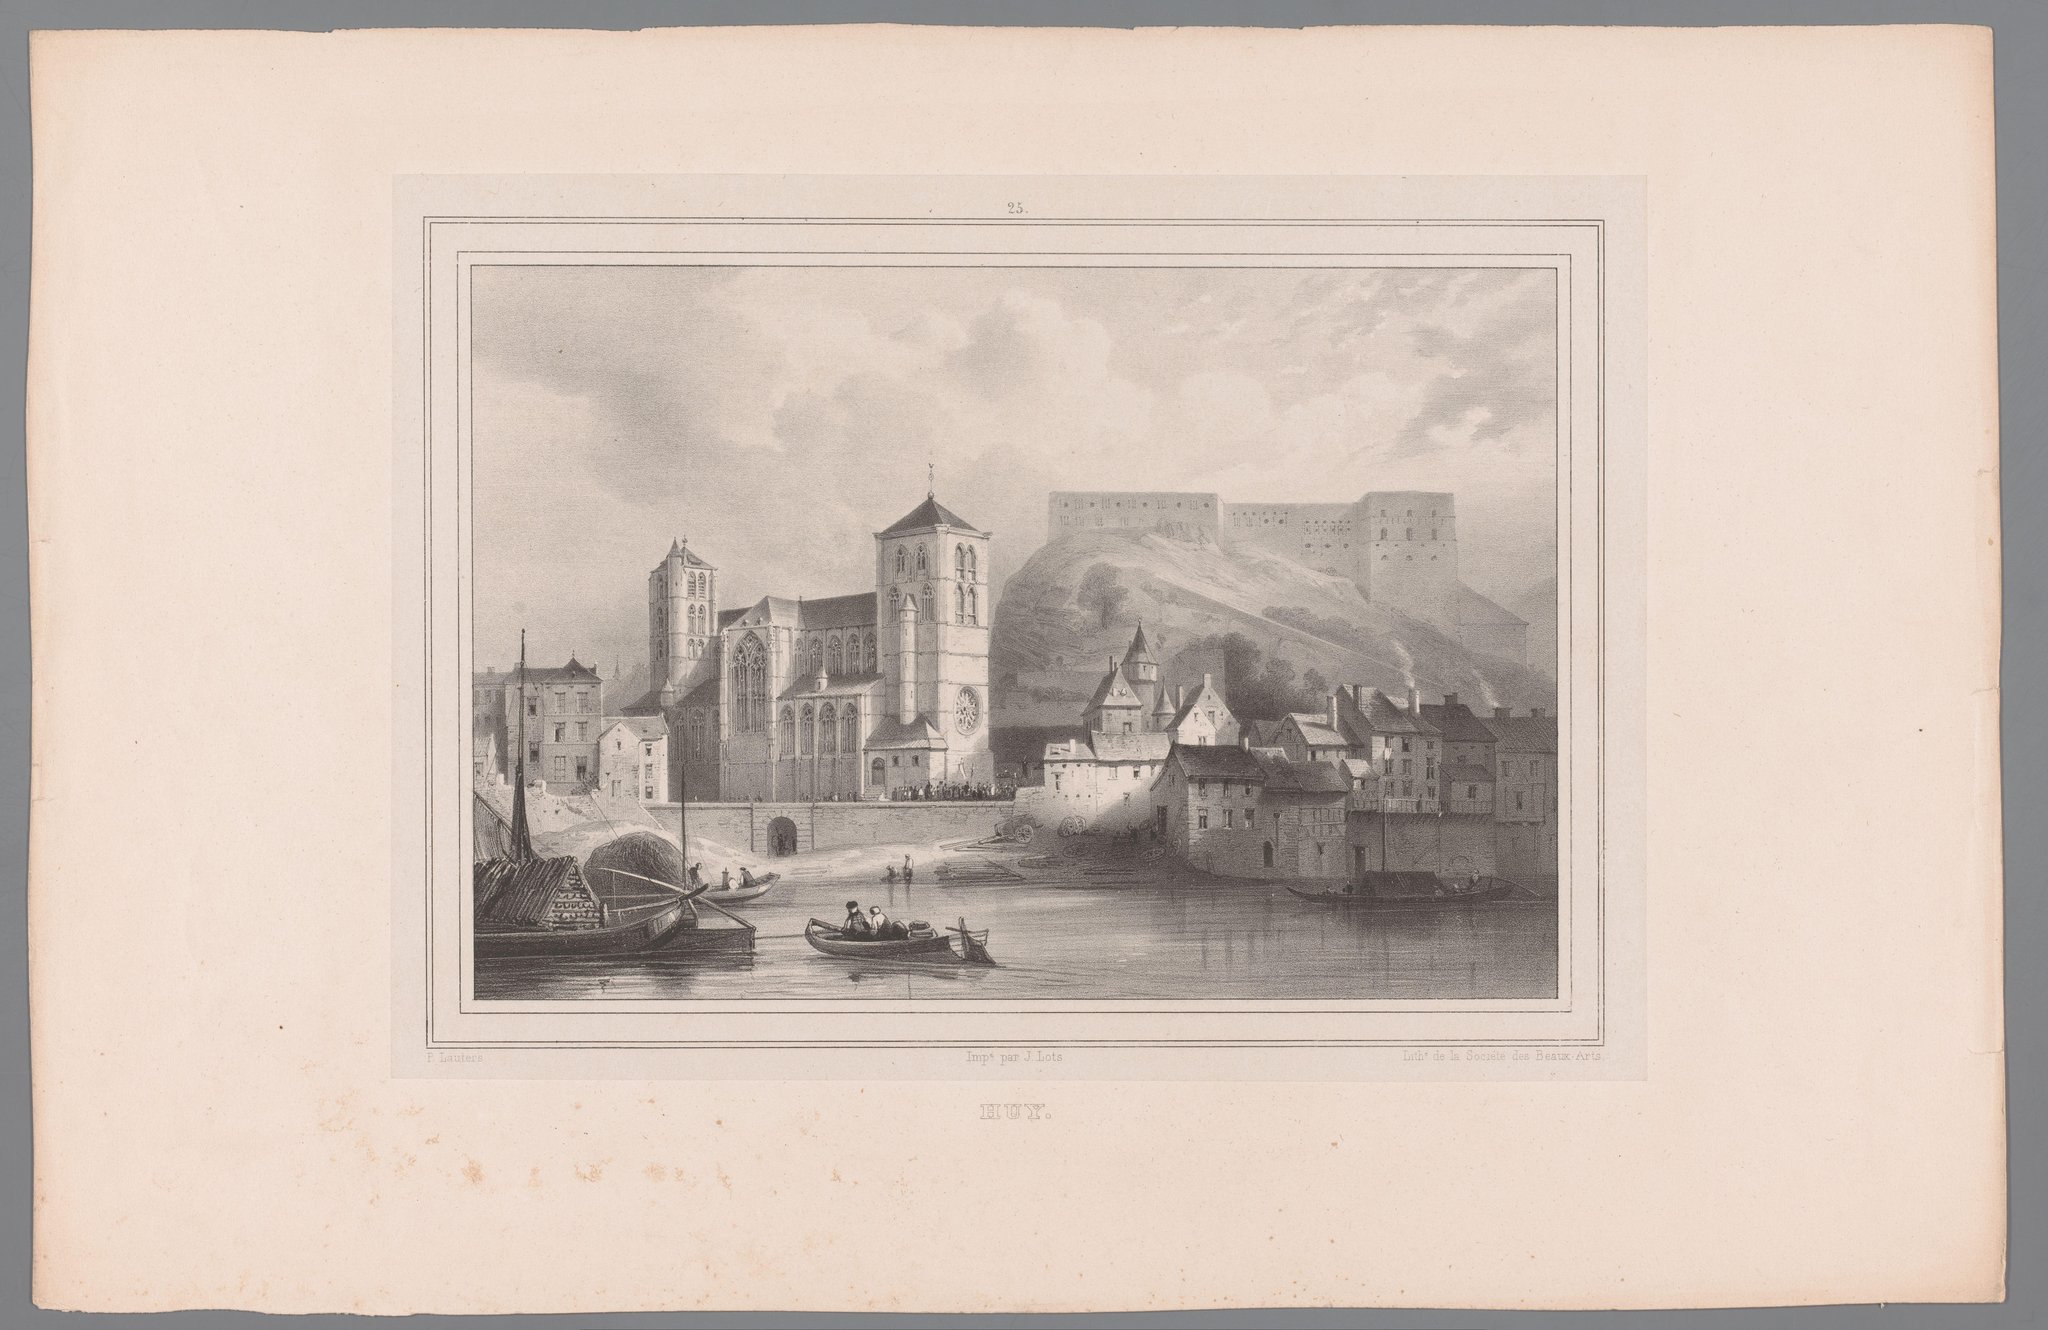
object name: print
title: Gezicht op Hoei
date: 1839-1841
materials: paper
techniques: lithograph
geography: brussels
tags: prospect of city, town panorama, silhouette of city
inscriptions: collector's mark: Lugt 2228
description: Prent verschenen in: Van Hasselt, André. Voyage aux bords de la Meuse. Brussel: Société des Beaux-Arts, 1839-1841. Deze publicatie bevat 36 litho's.